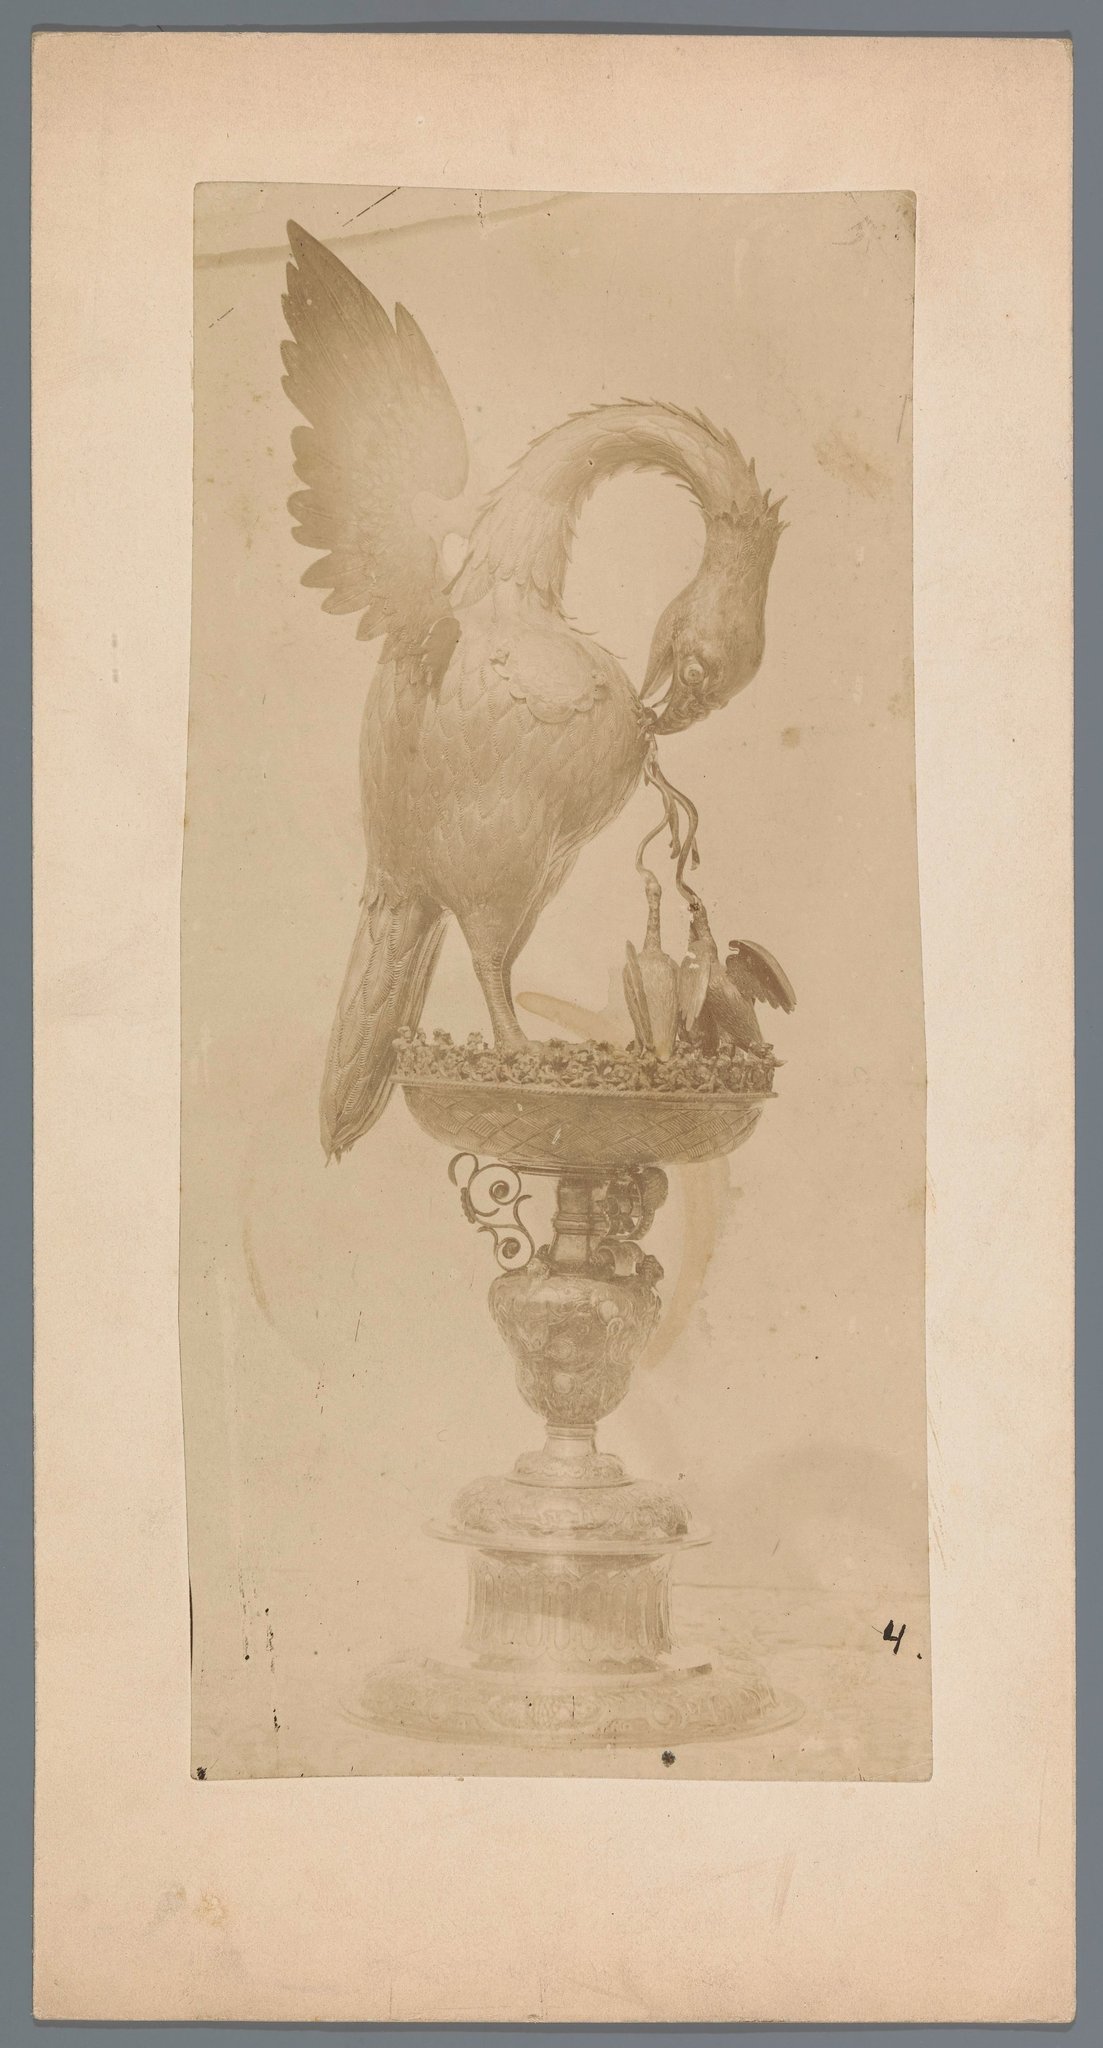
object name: photograph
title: Kelk in de vorm van een pelikaan met jongen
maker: Anonymous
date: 1875-1900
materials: cardboard, photographic support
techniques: albumen print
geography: europe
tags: chalice, symbols of christ ~ animals, water-birds: pelican, europe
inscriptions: collector's mark: Lugt 3937, number: ‘4.’